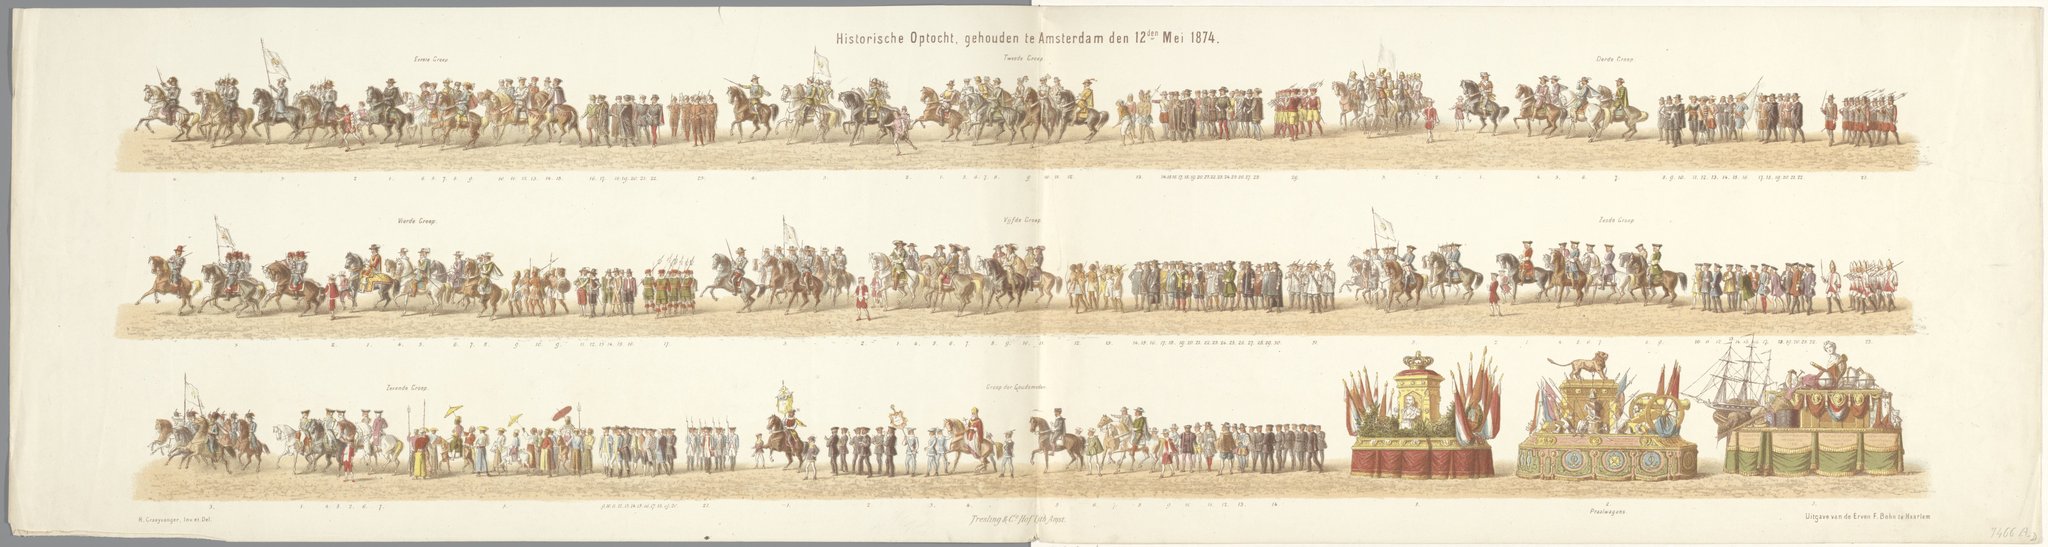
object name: print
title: Historische Optocht, gehouden te Amsterdam, 12 mei 1874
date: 1822-1880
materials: paper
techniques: lithograph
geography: amsterdam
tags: other festivities connected to calendar dates; memorial days (+ decorated float, wagon ~ festive activities), military parade, pageant, amsterdam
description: De optocht bestaat uit drie rijen met historische figuren die verschillende tijdvakken representeren. De optocht is verdeeld in acht groepen en drie praalwagens.